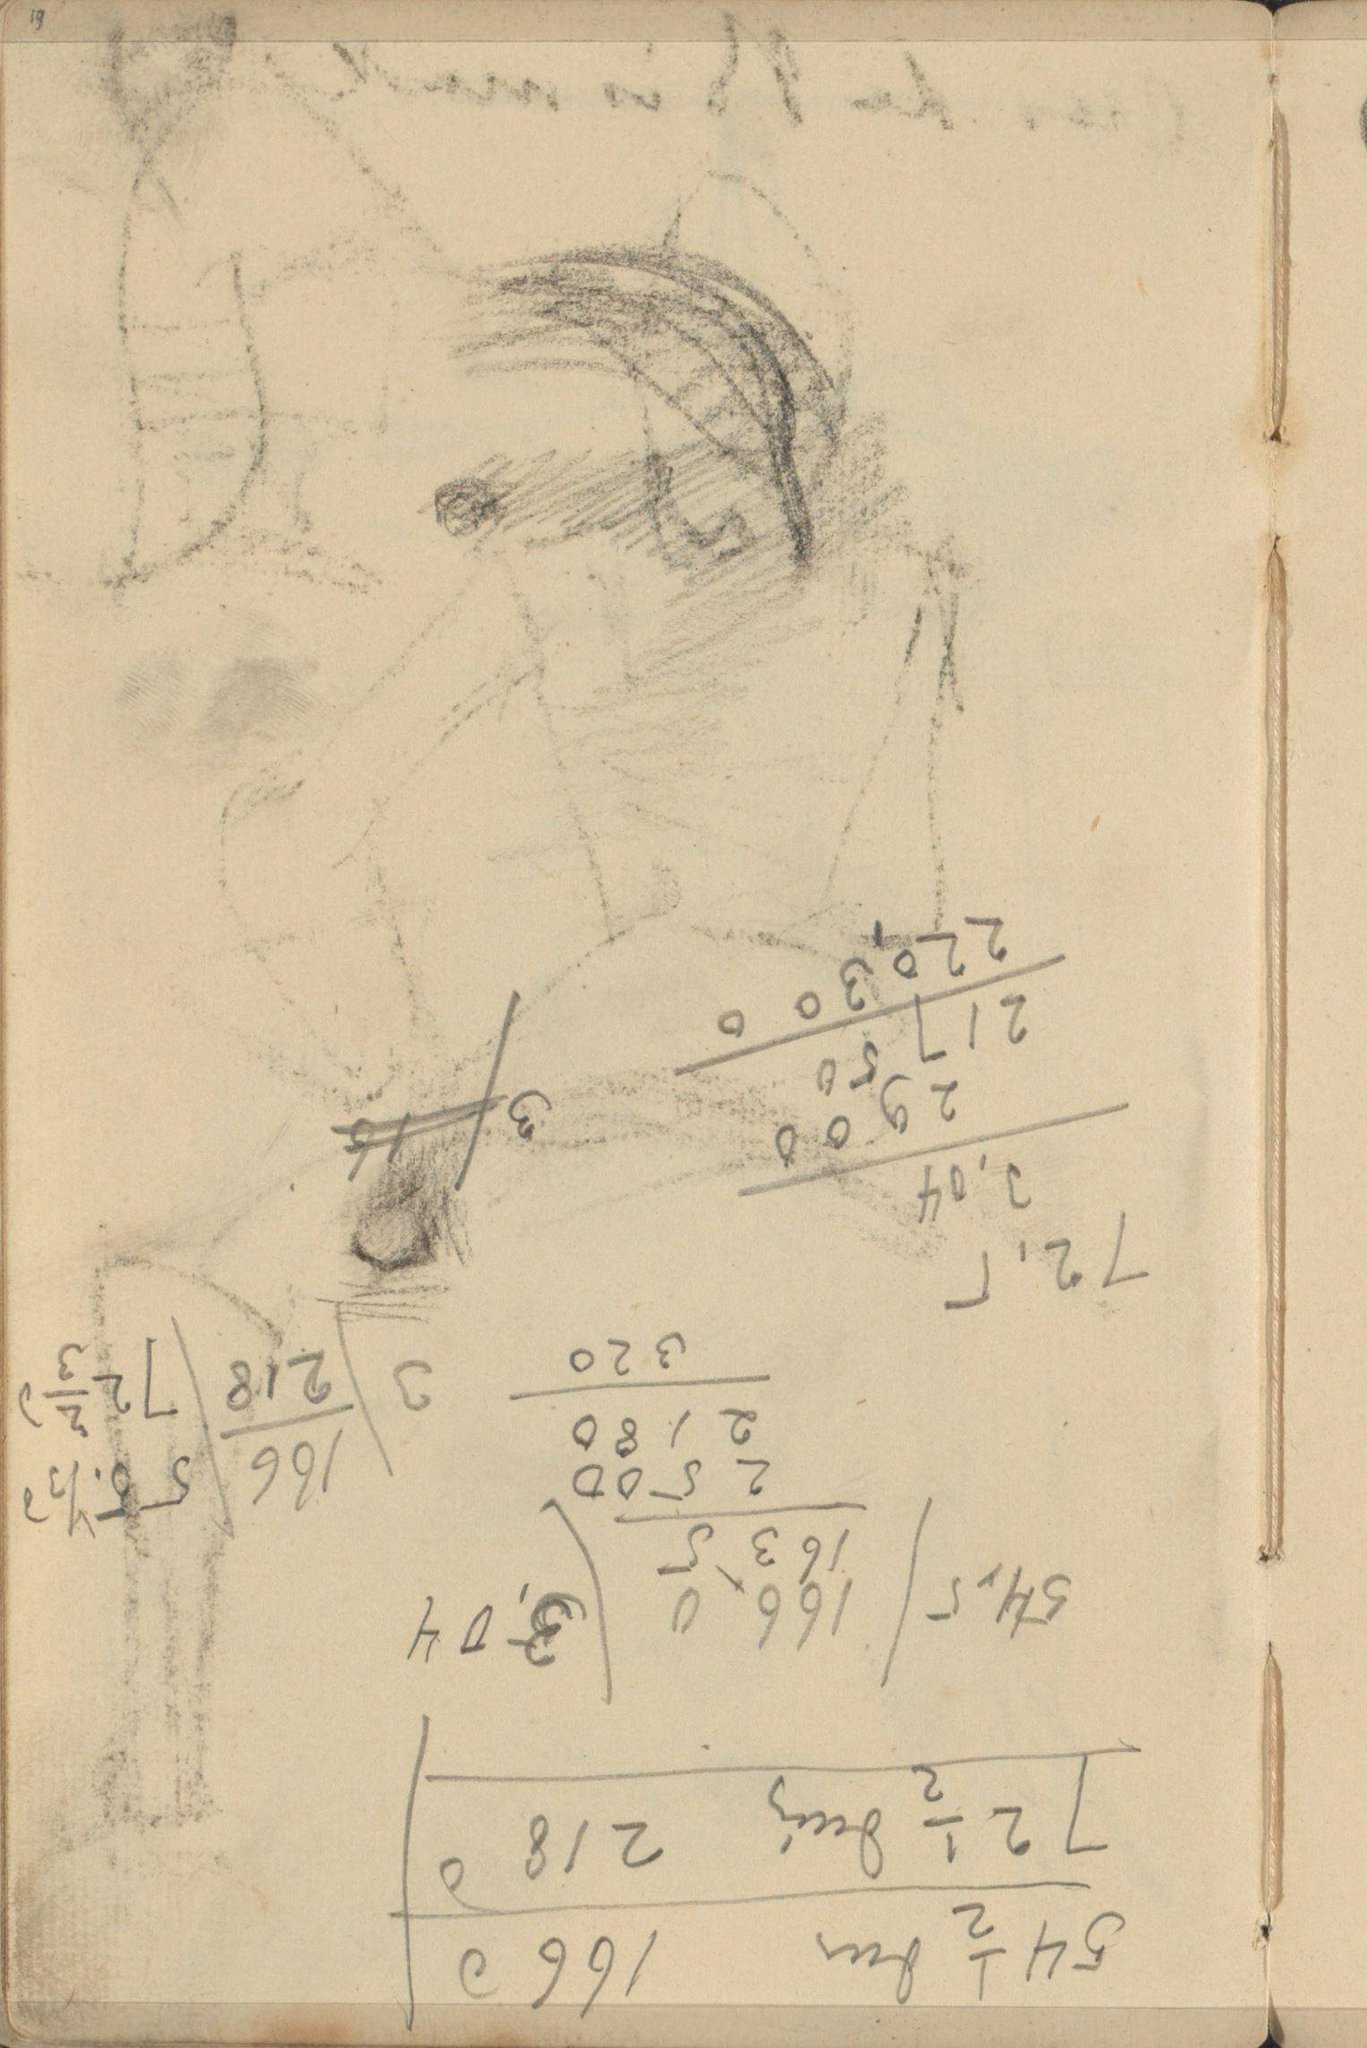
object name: sketchbook leaf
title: Studie, mogelijk van een hoofd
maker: george hendrik breitner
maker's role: draughtsman, painter, print maker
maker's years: 1857-1923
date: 1880-1882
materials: chalk, paper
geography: the hague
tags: head (human)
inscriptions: annotation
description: Pagina 19 uit een schetsboek met 19 bladen.